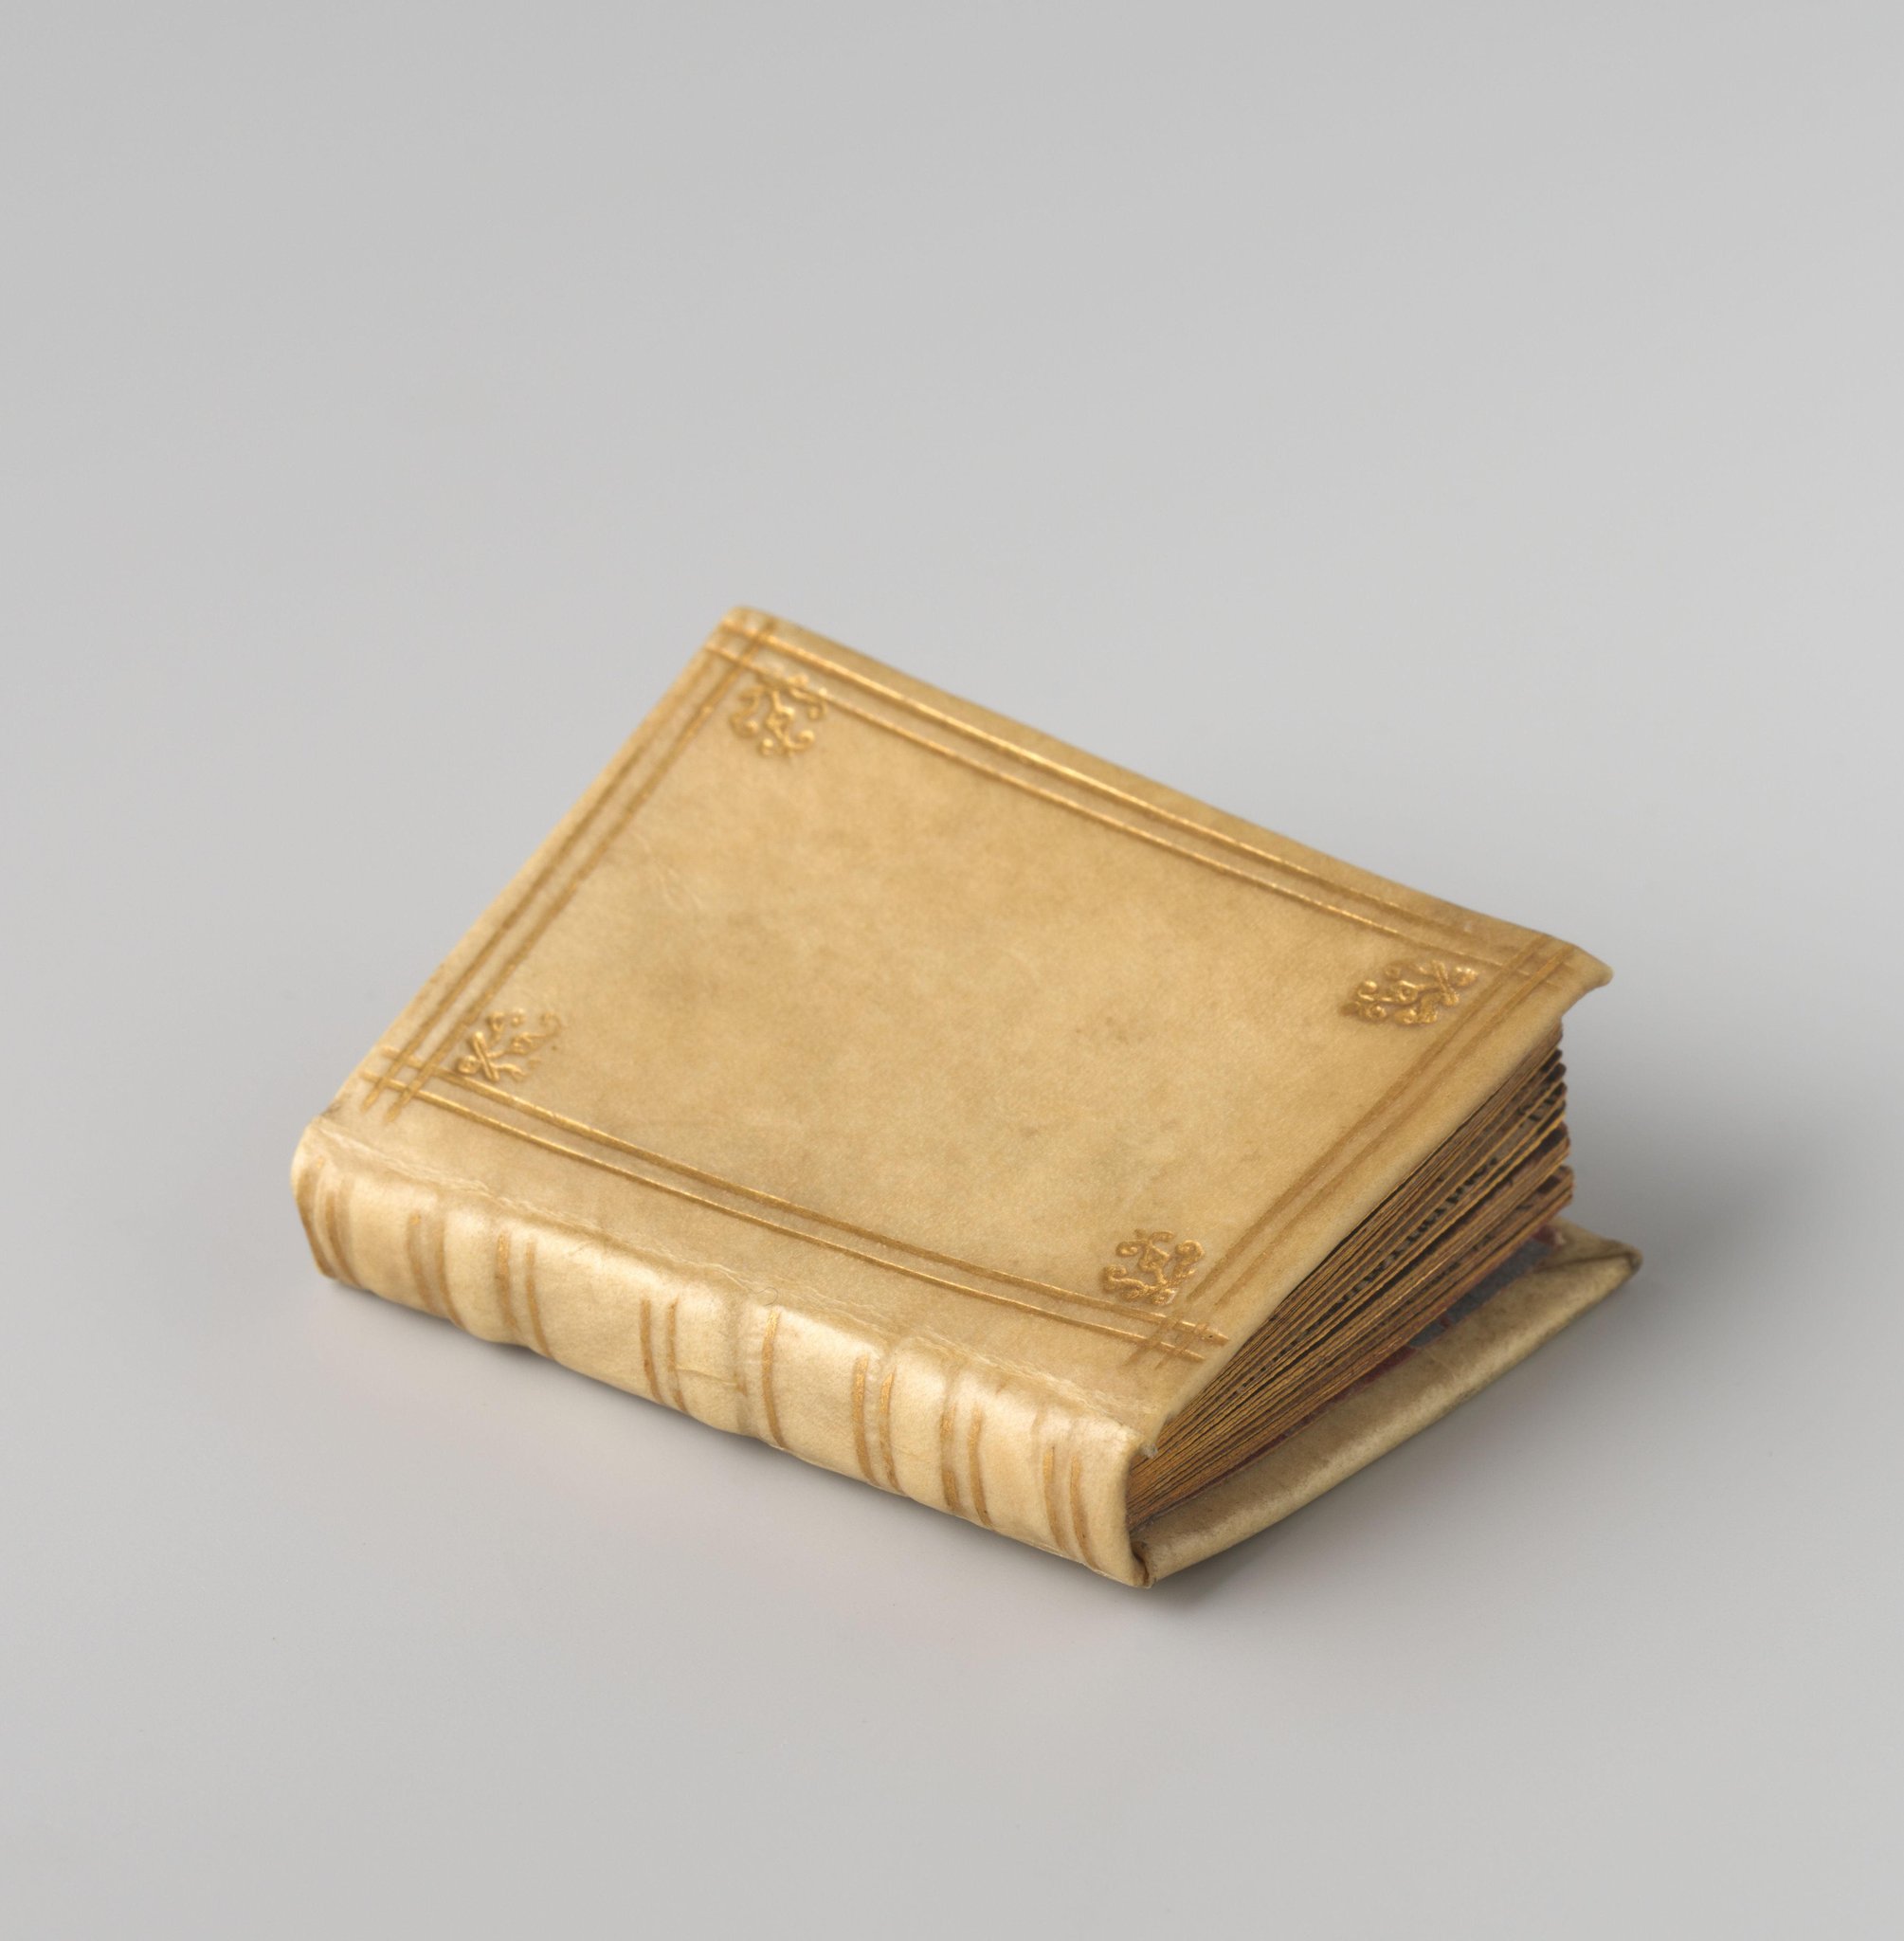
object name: miniature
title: Boek met landkaarten van Oost-Europa en Noord-Afrika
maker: Anonymous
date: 1690-1710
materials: gold, paper, parchment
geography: amsterdam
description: Boek met landkaarten van Oost-Europa en Noord-Afrika. Ingebonden in perkament met goudopdruk.